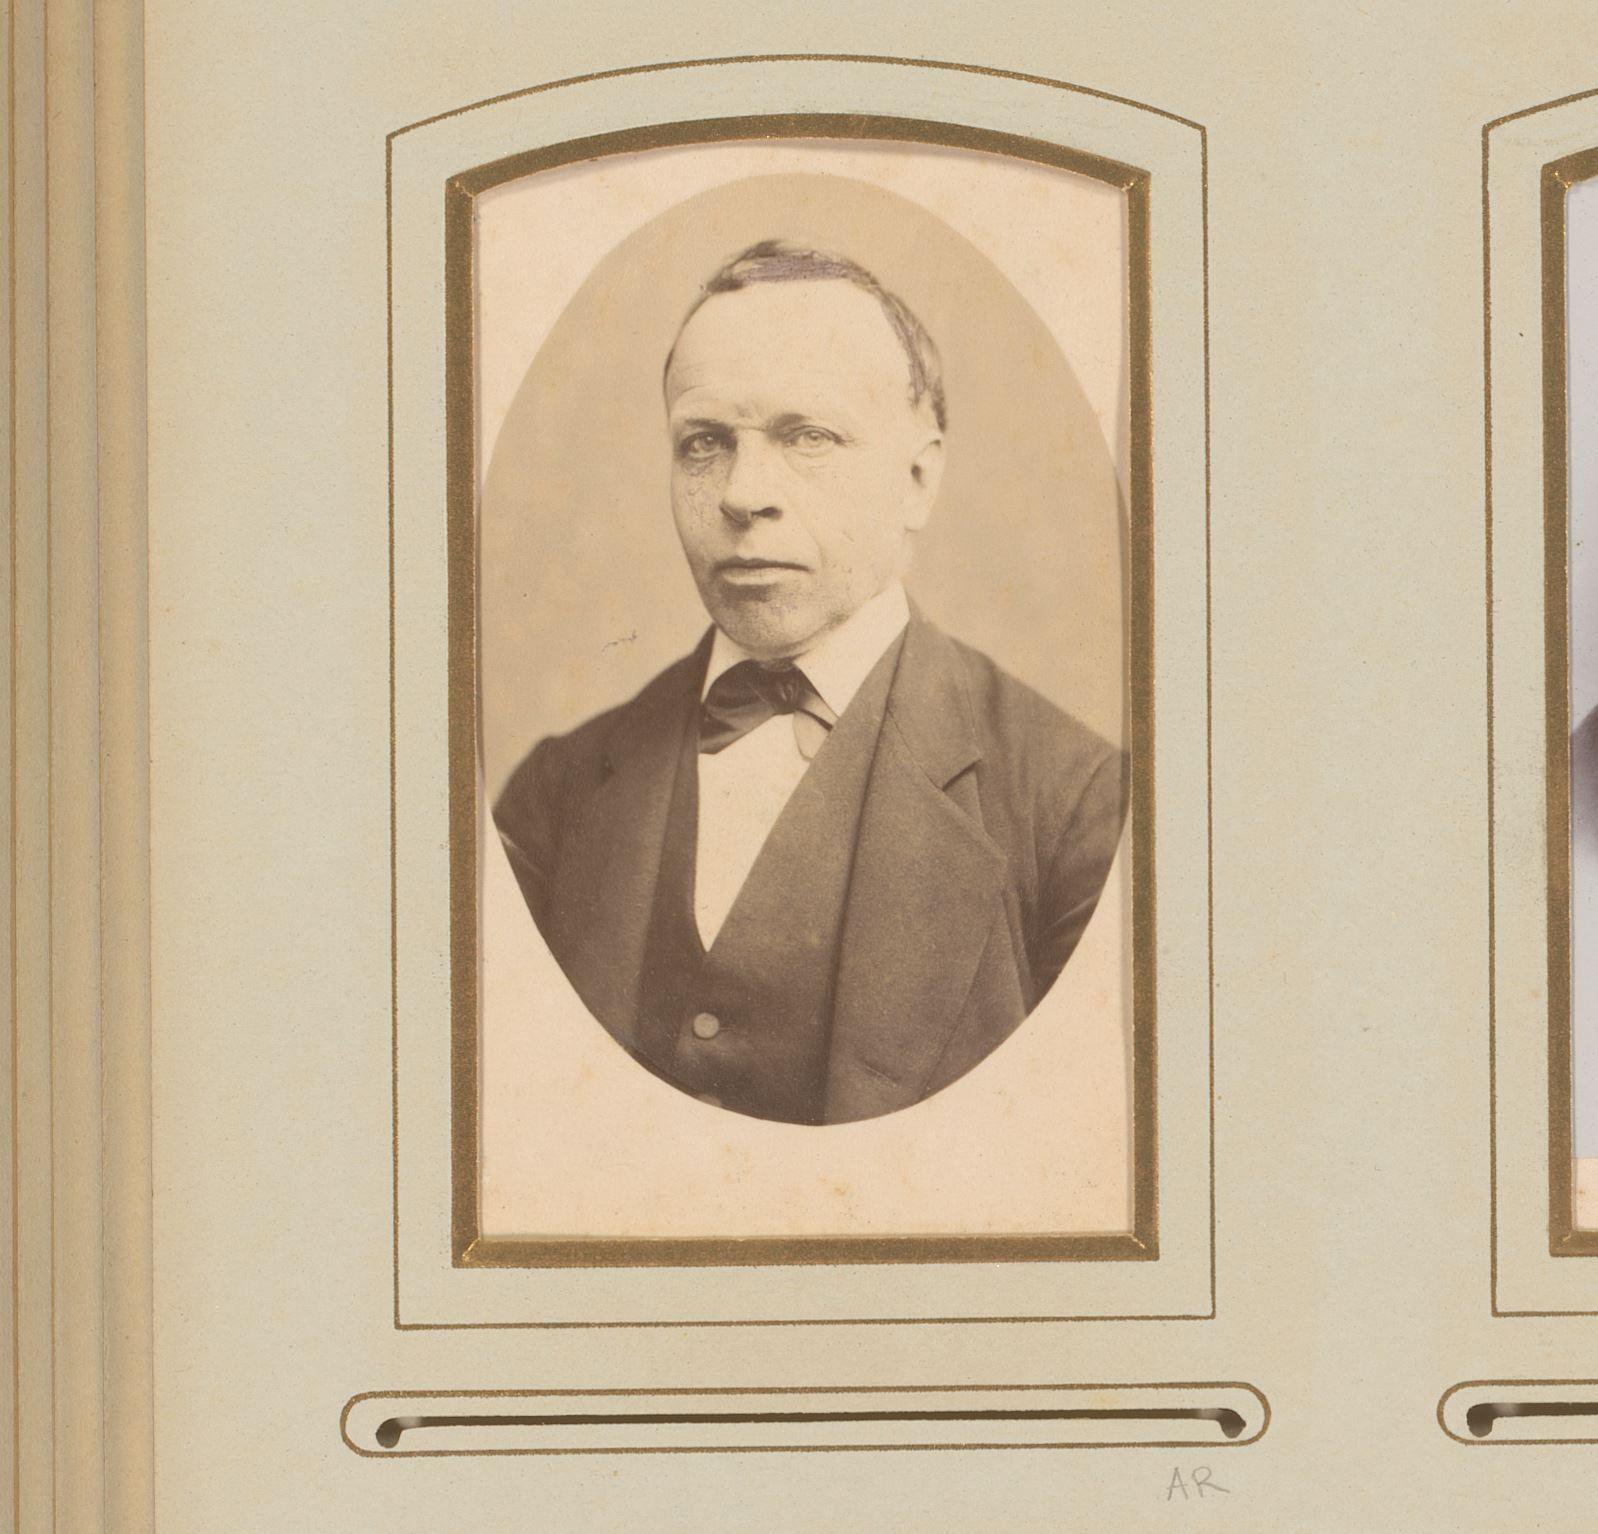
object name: album leaf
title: Portret van een man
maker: friedrich julius von kolkow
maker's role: fotograaf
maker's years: 1839-1914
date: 1873-1900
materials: cardboard, photographic support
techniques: albumen print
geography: groningen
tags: historical persons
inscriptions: inscription: ‘WERELD-TENTOONSTELLING/ WEENEN/ VERDIENST-MEDAILLE./ 1873./ (...)/ Fr. Jul. von Kolkow/ Hof-Photograph/ Z.K.H. Prins Hendrik der Nederlanden./ Groningen.’